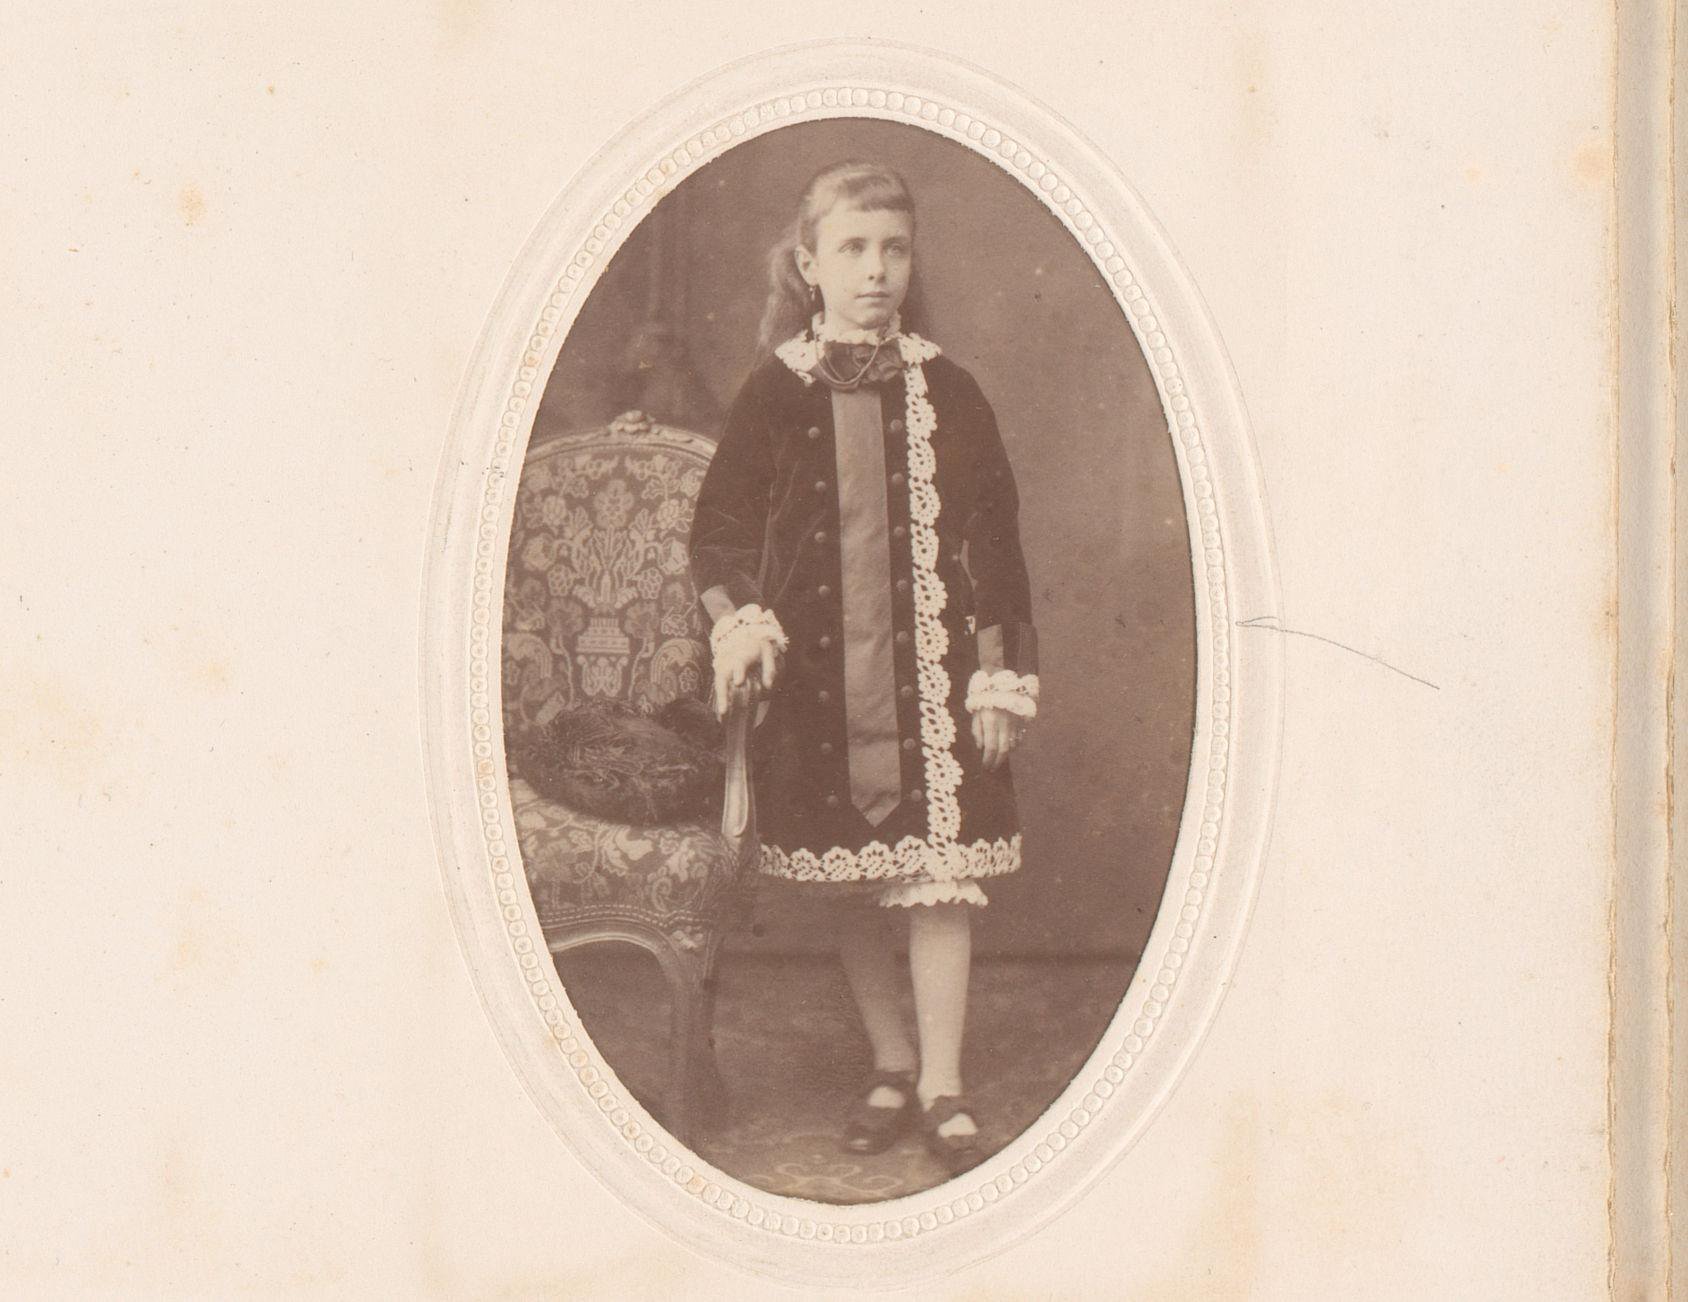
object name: album leaf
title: Portret van een meisje in jas over kanten broek, staand bij een stoel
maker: mathieu-deroche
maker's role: fotograaf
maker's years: 1837-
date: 1873-1900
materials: cardboard, paper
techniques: albumen print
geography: paris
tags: historical persons - bb - woman, girl (child between toddler and youth), chair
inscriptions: inscription: ‘Mathieu-Deroche/ Photographe de S.A.R. le Prince de Galles/ Bould des Capucines/ 39/ a Paris/ PROCÉDÉ DEROCHE/ Specialité de Portraits sur Email/ MÉDAILLE D'ARGENT/ Exposition/ 1873.’